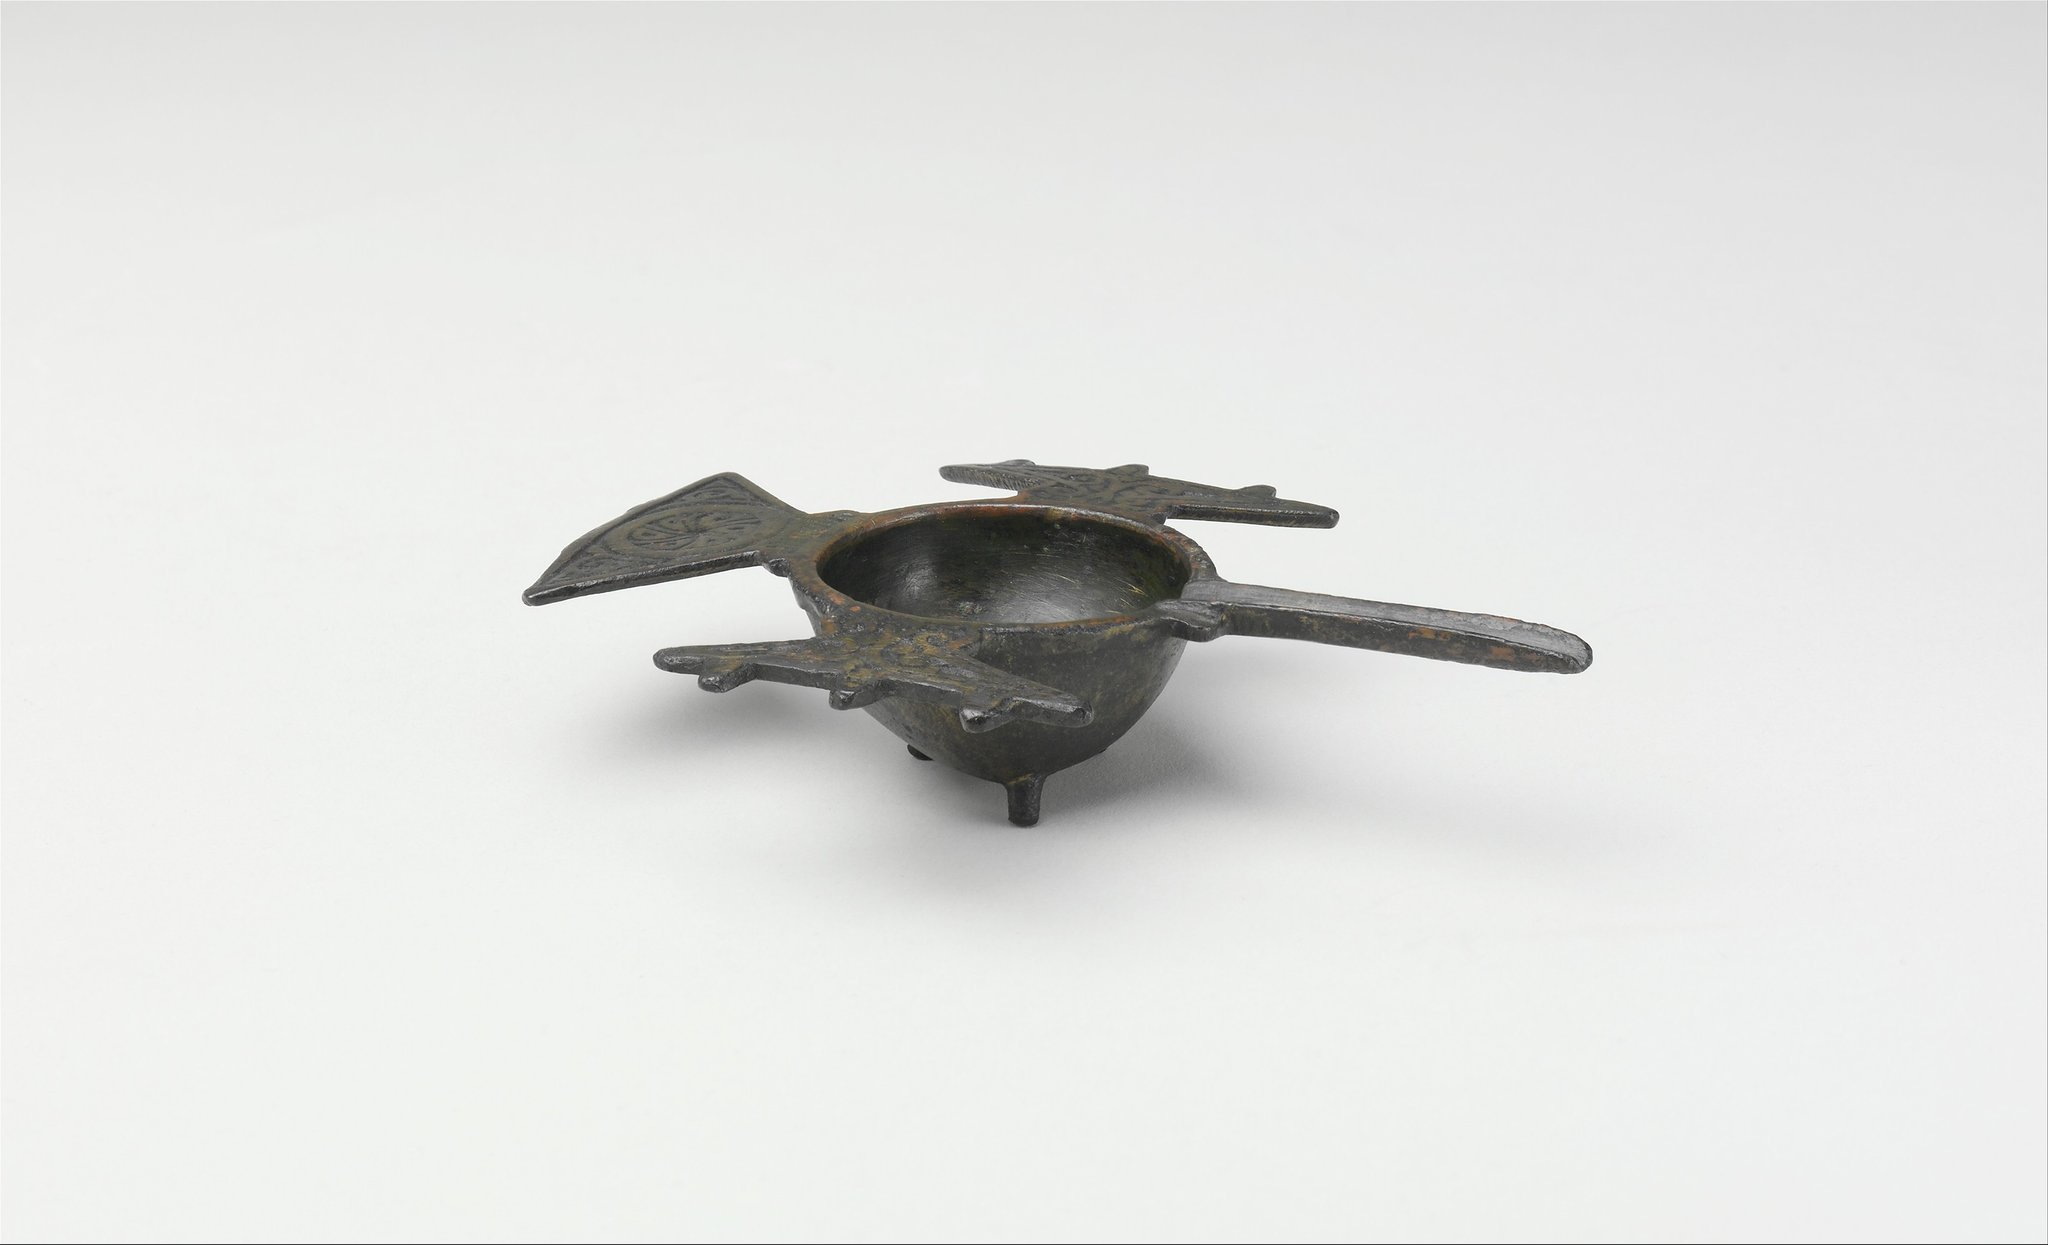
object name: cosmetic mortar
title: Cosmetics Mortar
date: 901-1200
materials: bronze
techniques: casting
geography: iran